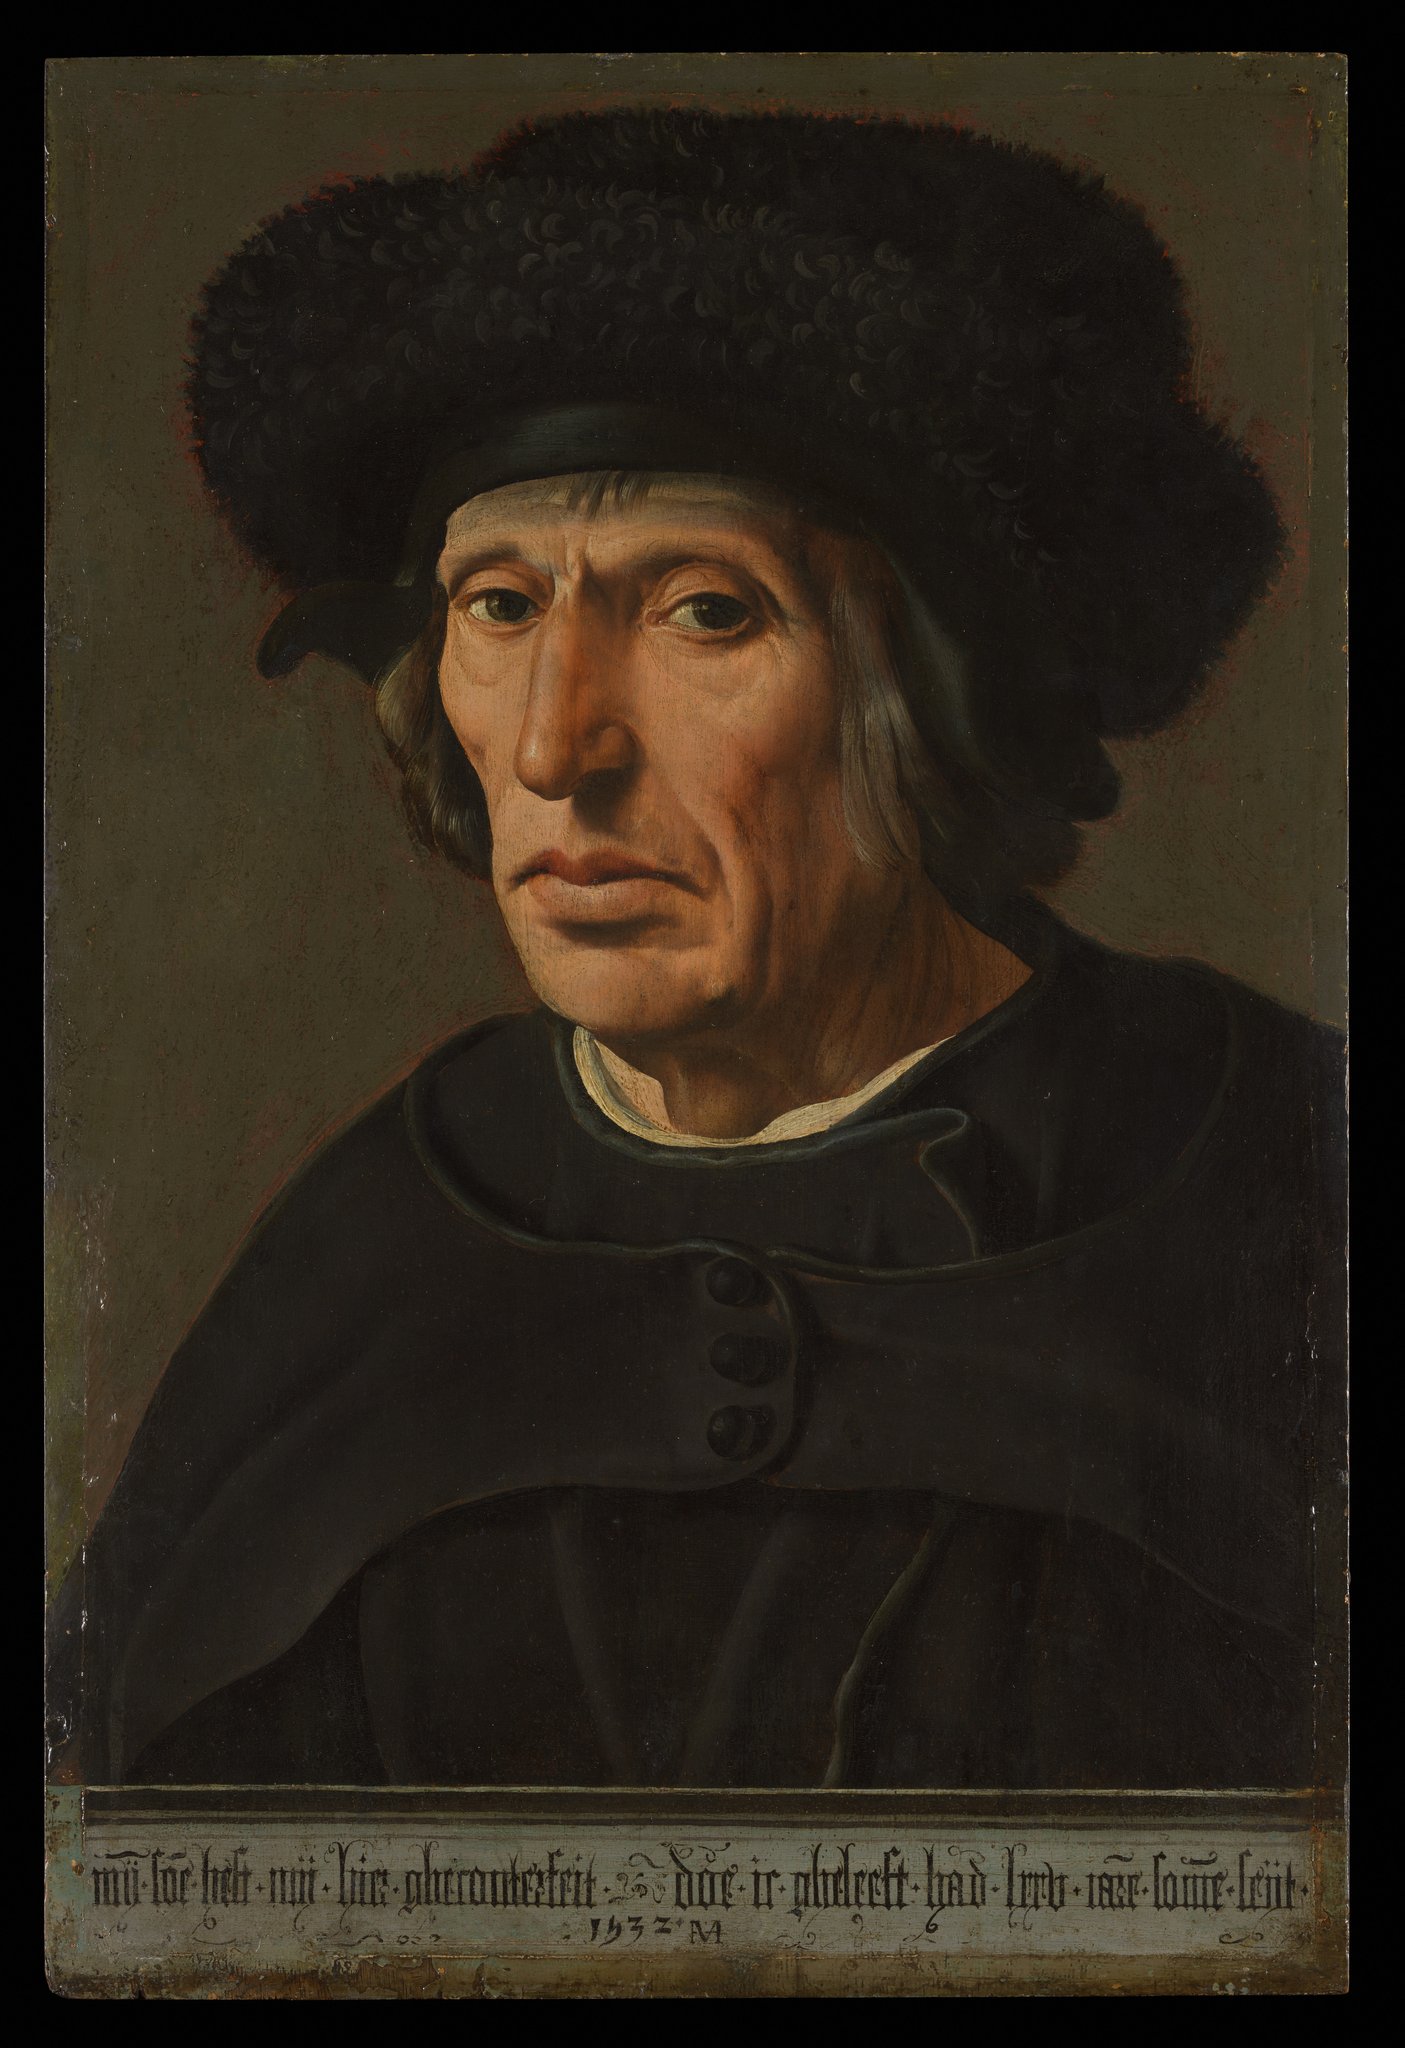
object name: painting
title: Jacob Willemsz van Veen (1456–1535), the Artist's Father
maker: maarten van heemskerck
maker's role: artist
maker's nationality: netherlandish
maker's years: 1498-1574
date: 1532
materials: oil, wood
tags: men,portraits